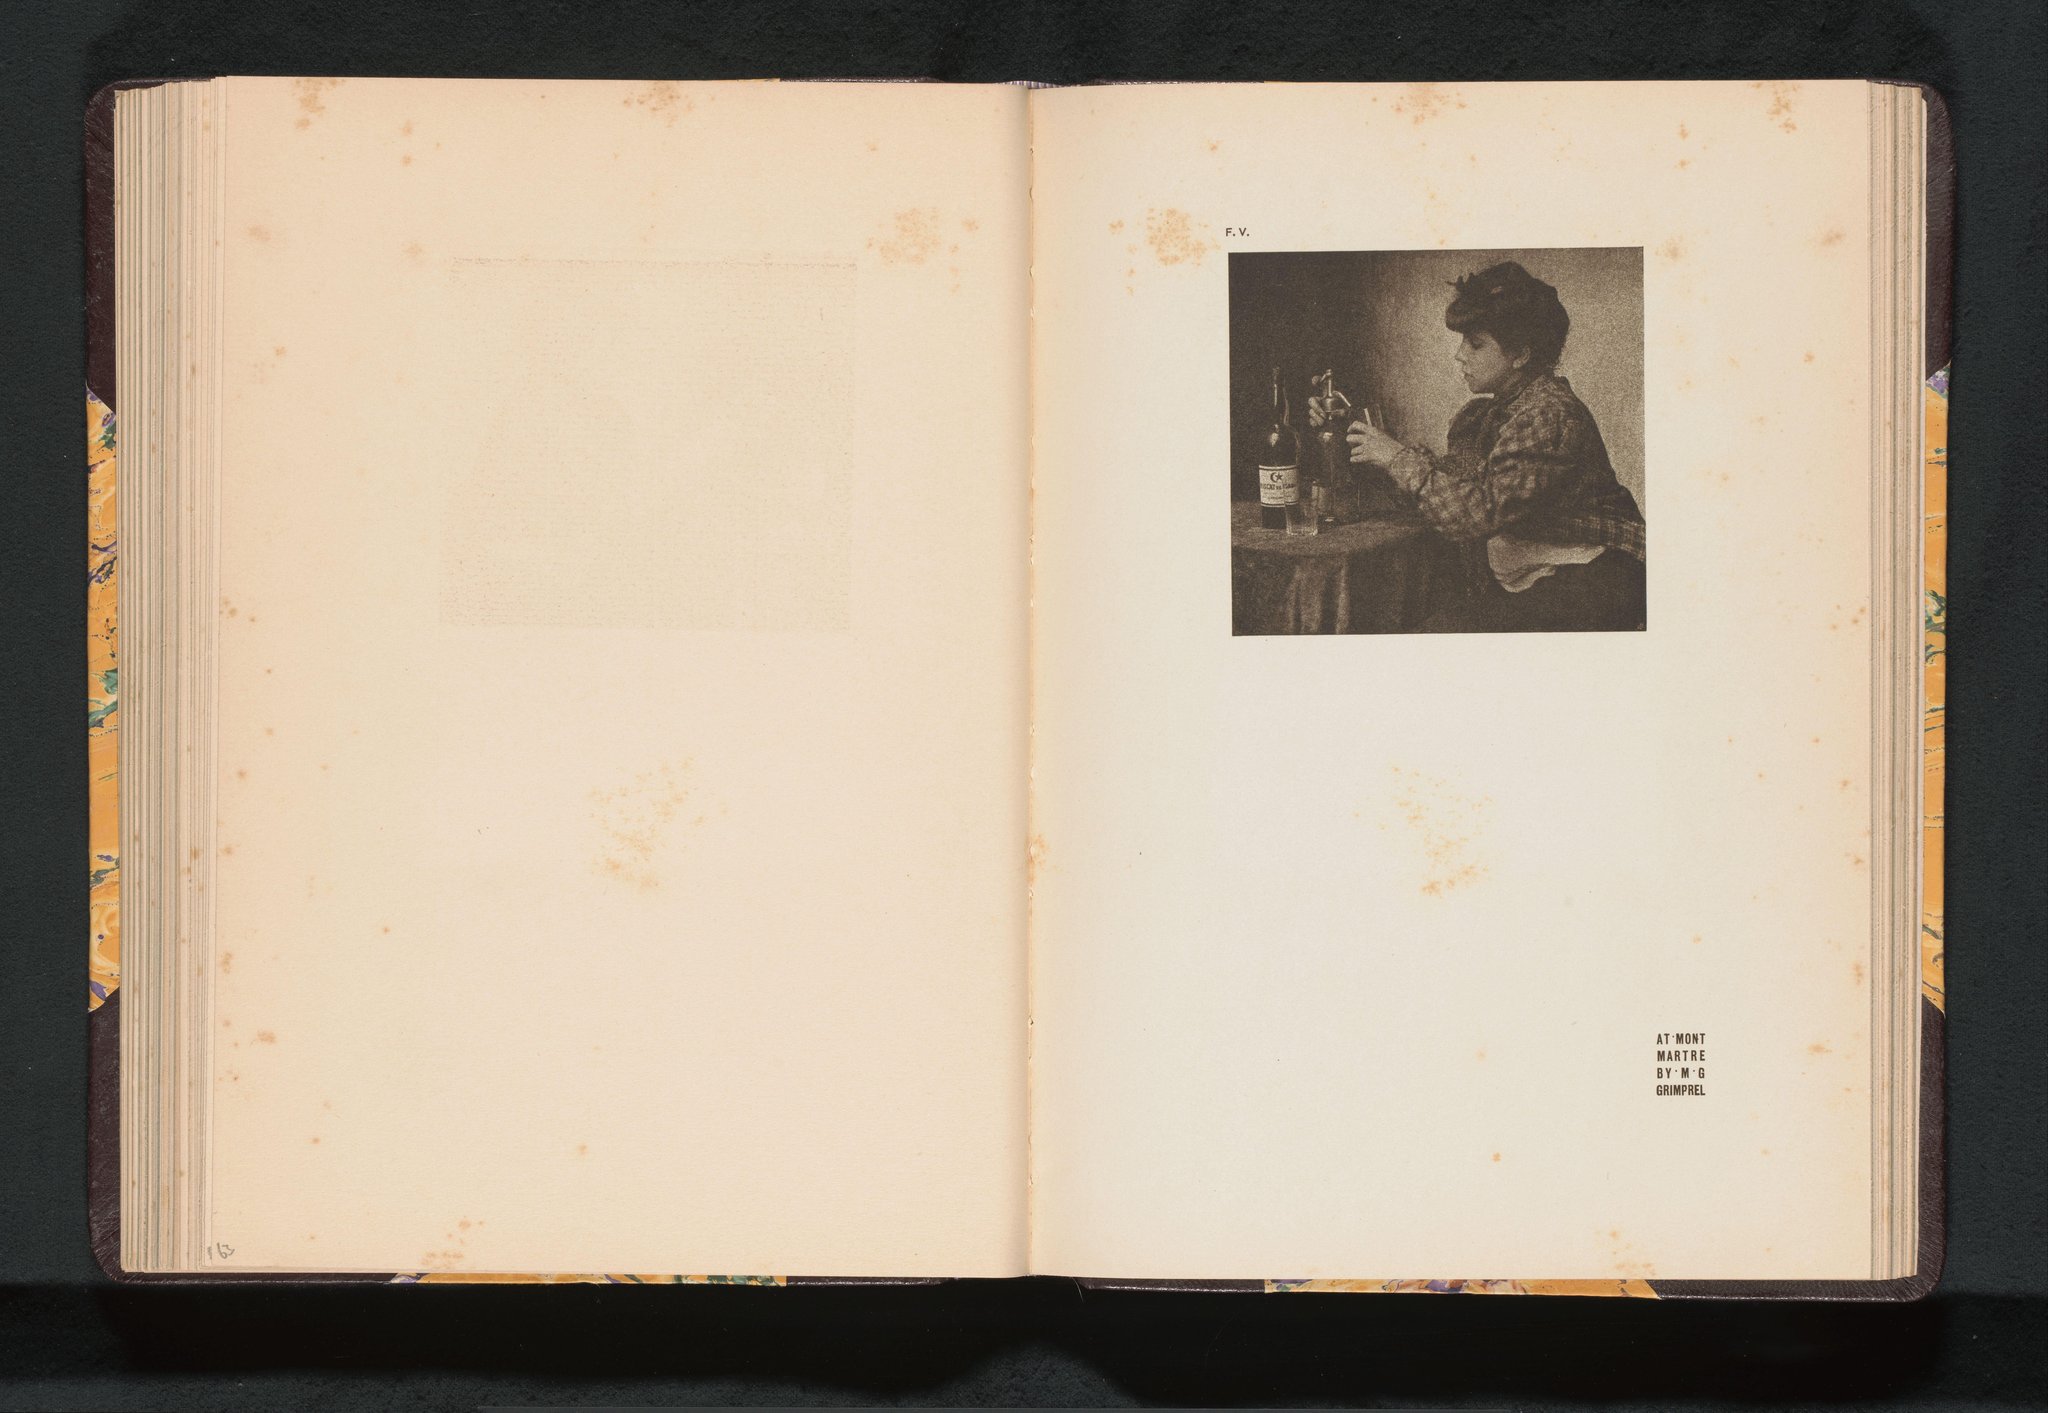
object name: photomechanical print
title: Drinkende vrouw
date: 1900-1905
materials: paper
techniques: collo-autotype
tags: pouring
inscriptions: inscription: ‘F. V.’, inscription: ‘At Montmartre by M.G. Grimprel’